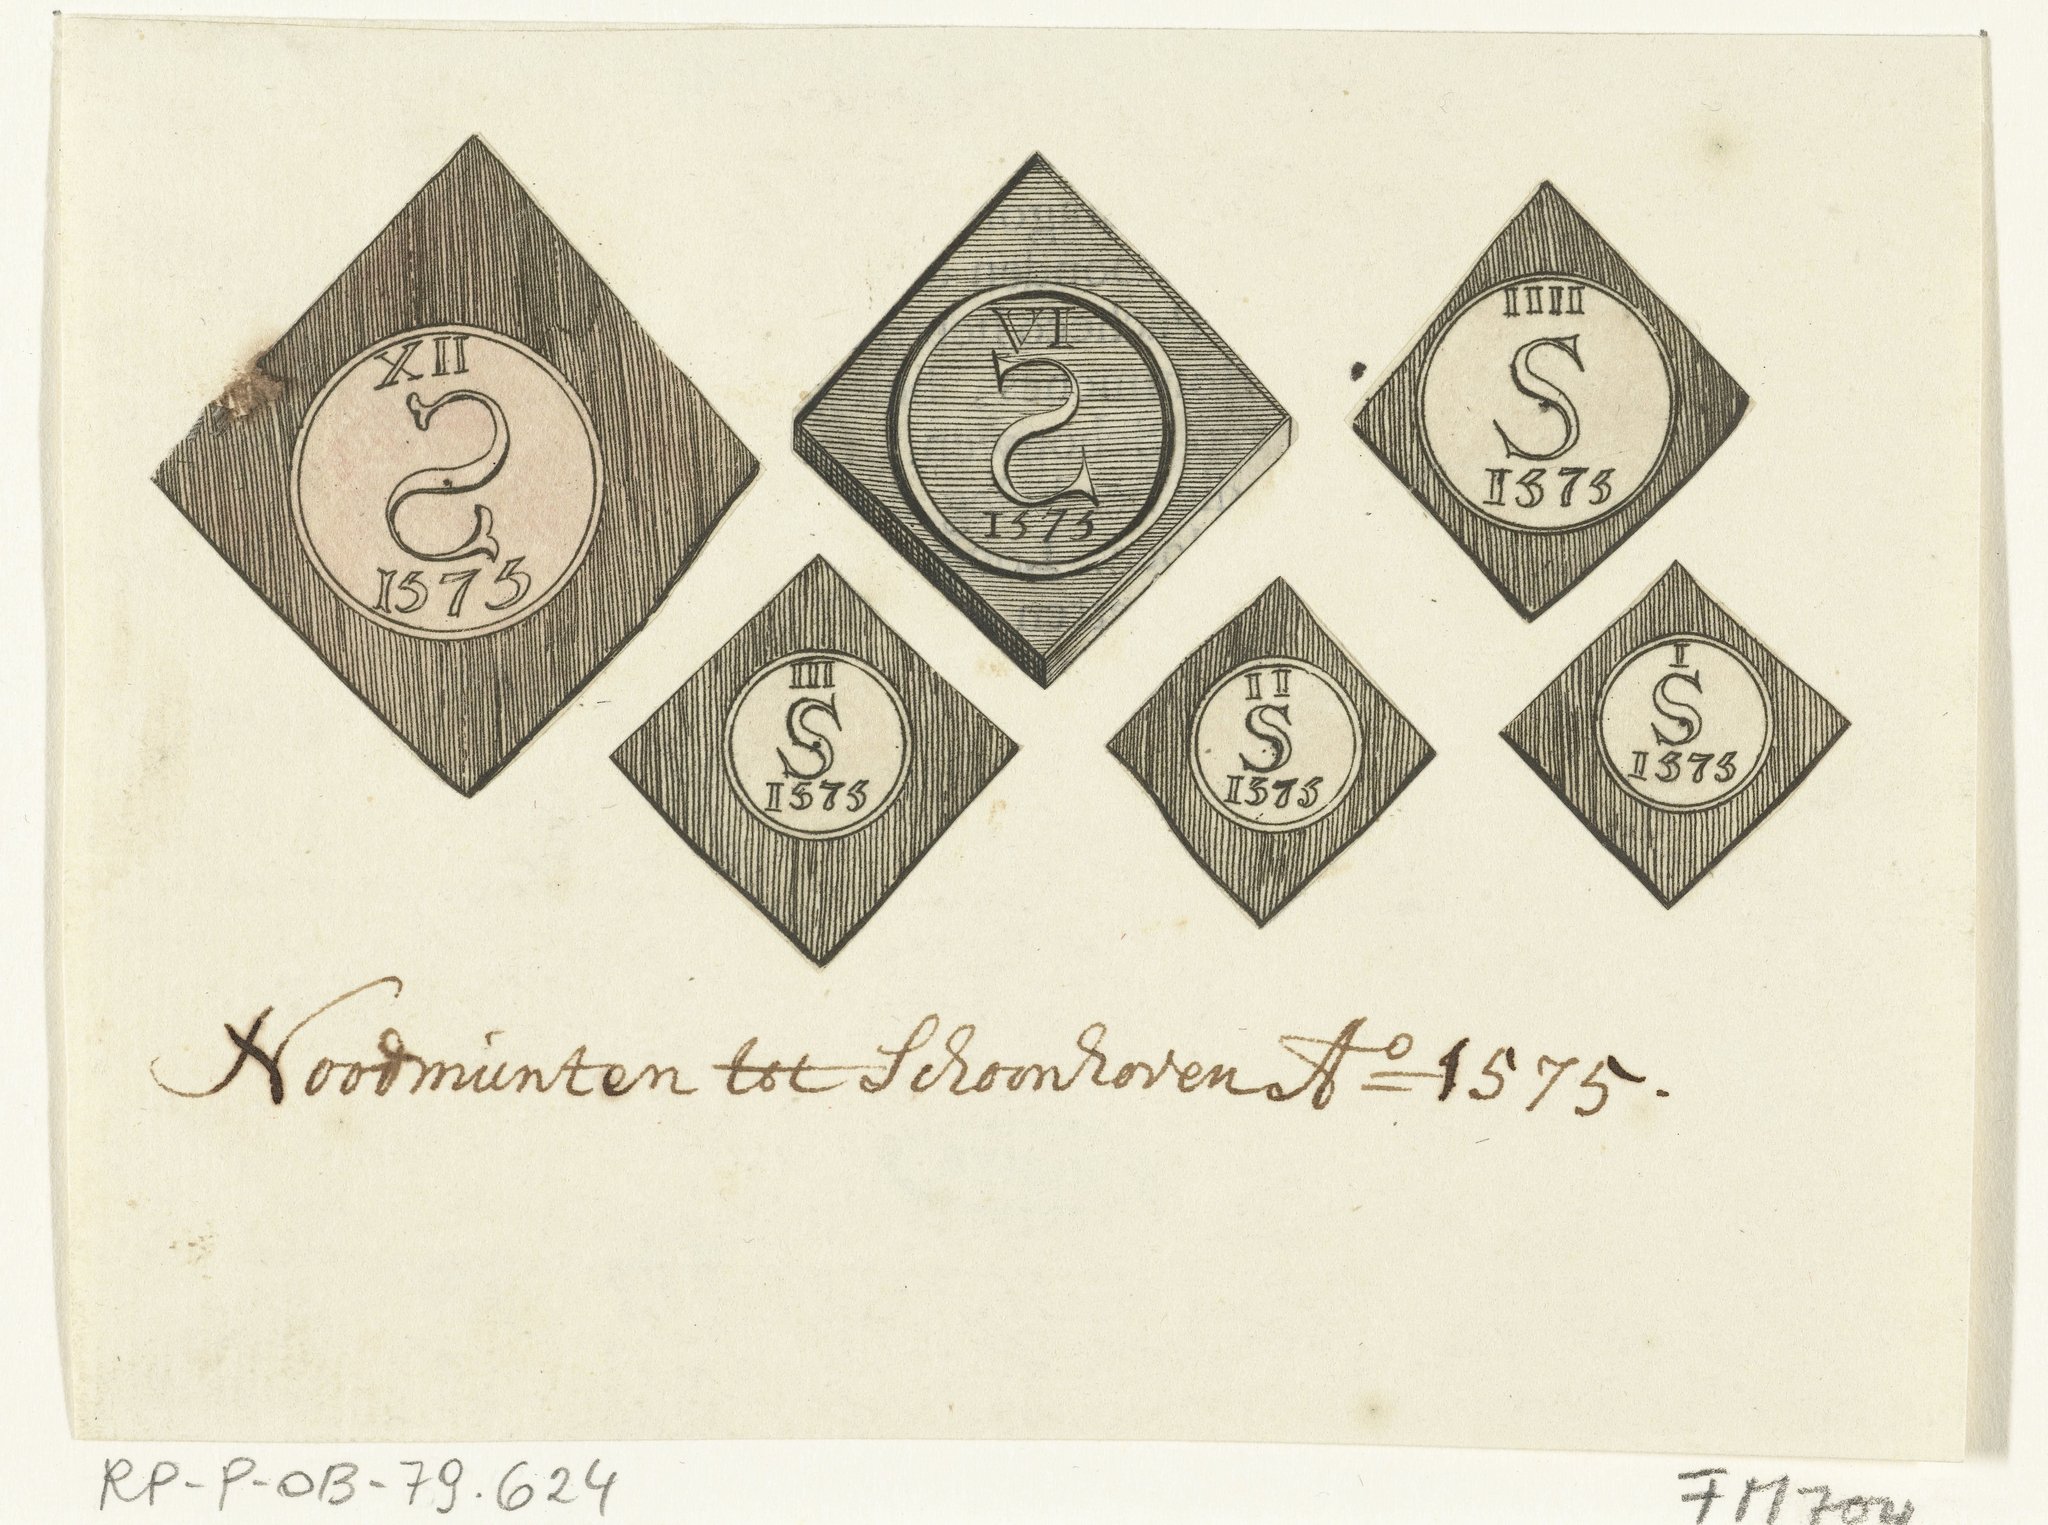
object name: print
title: Zes noodmunten geslagen tijdens het beleg van Schoonhoven, 1575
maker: Anonymous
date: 1600-1799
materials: paper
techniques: etching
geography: netherlands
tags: coin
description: Zes noodmunten geslagen tijdens het beleg van Schoonhoven, 1575. Op de voorzijde: I-IIII, VI en XII, S 1575. Uitgeknipt en opgeplakt, met handgeschreven opschrift.